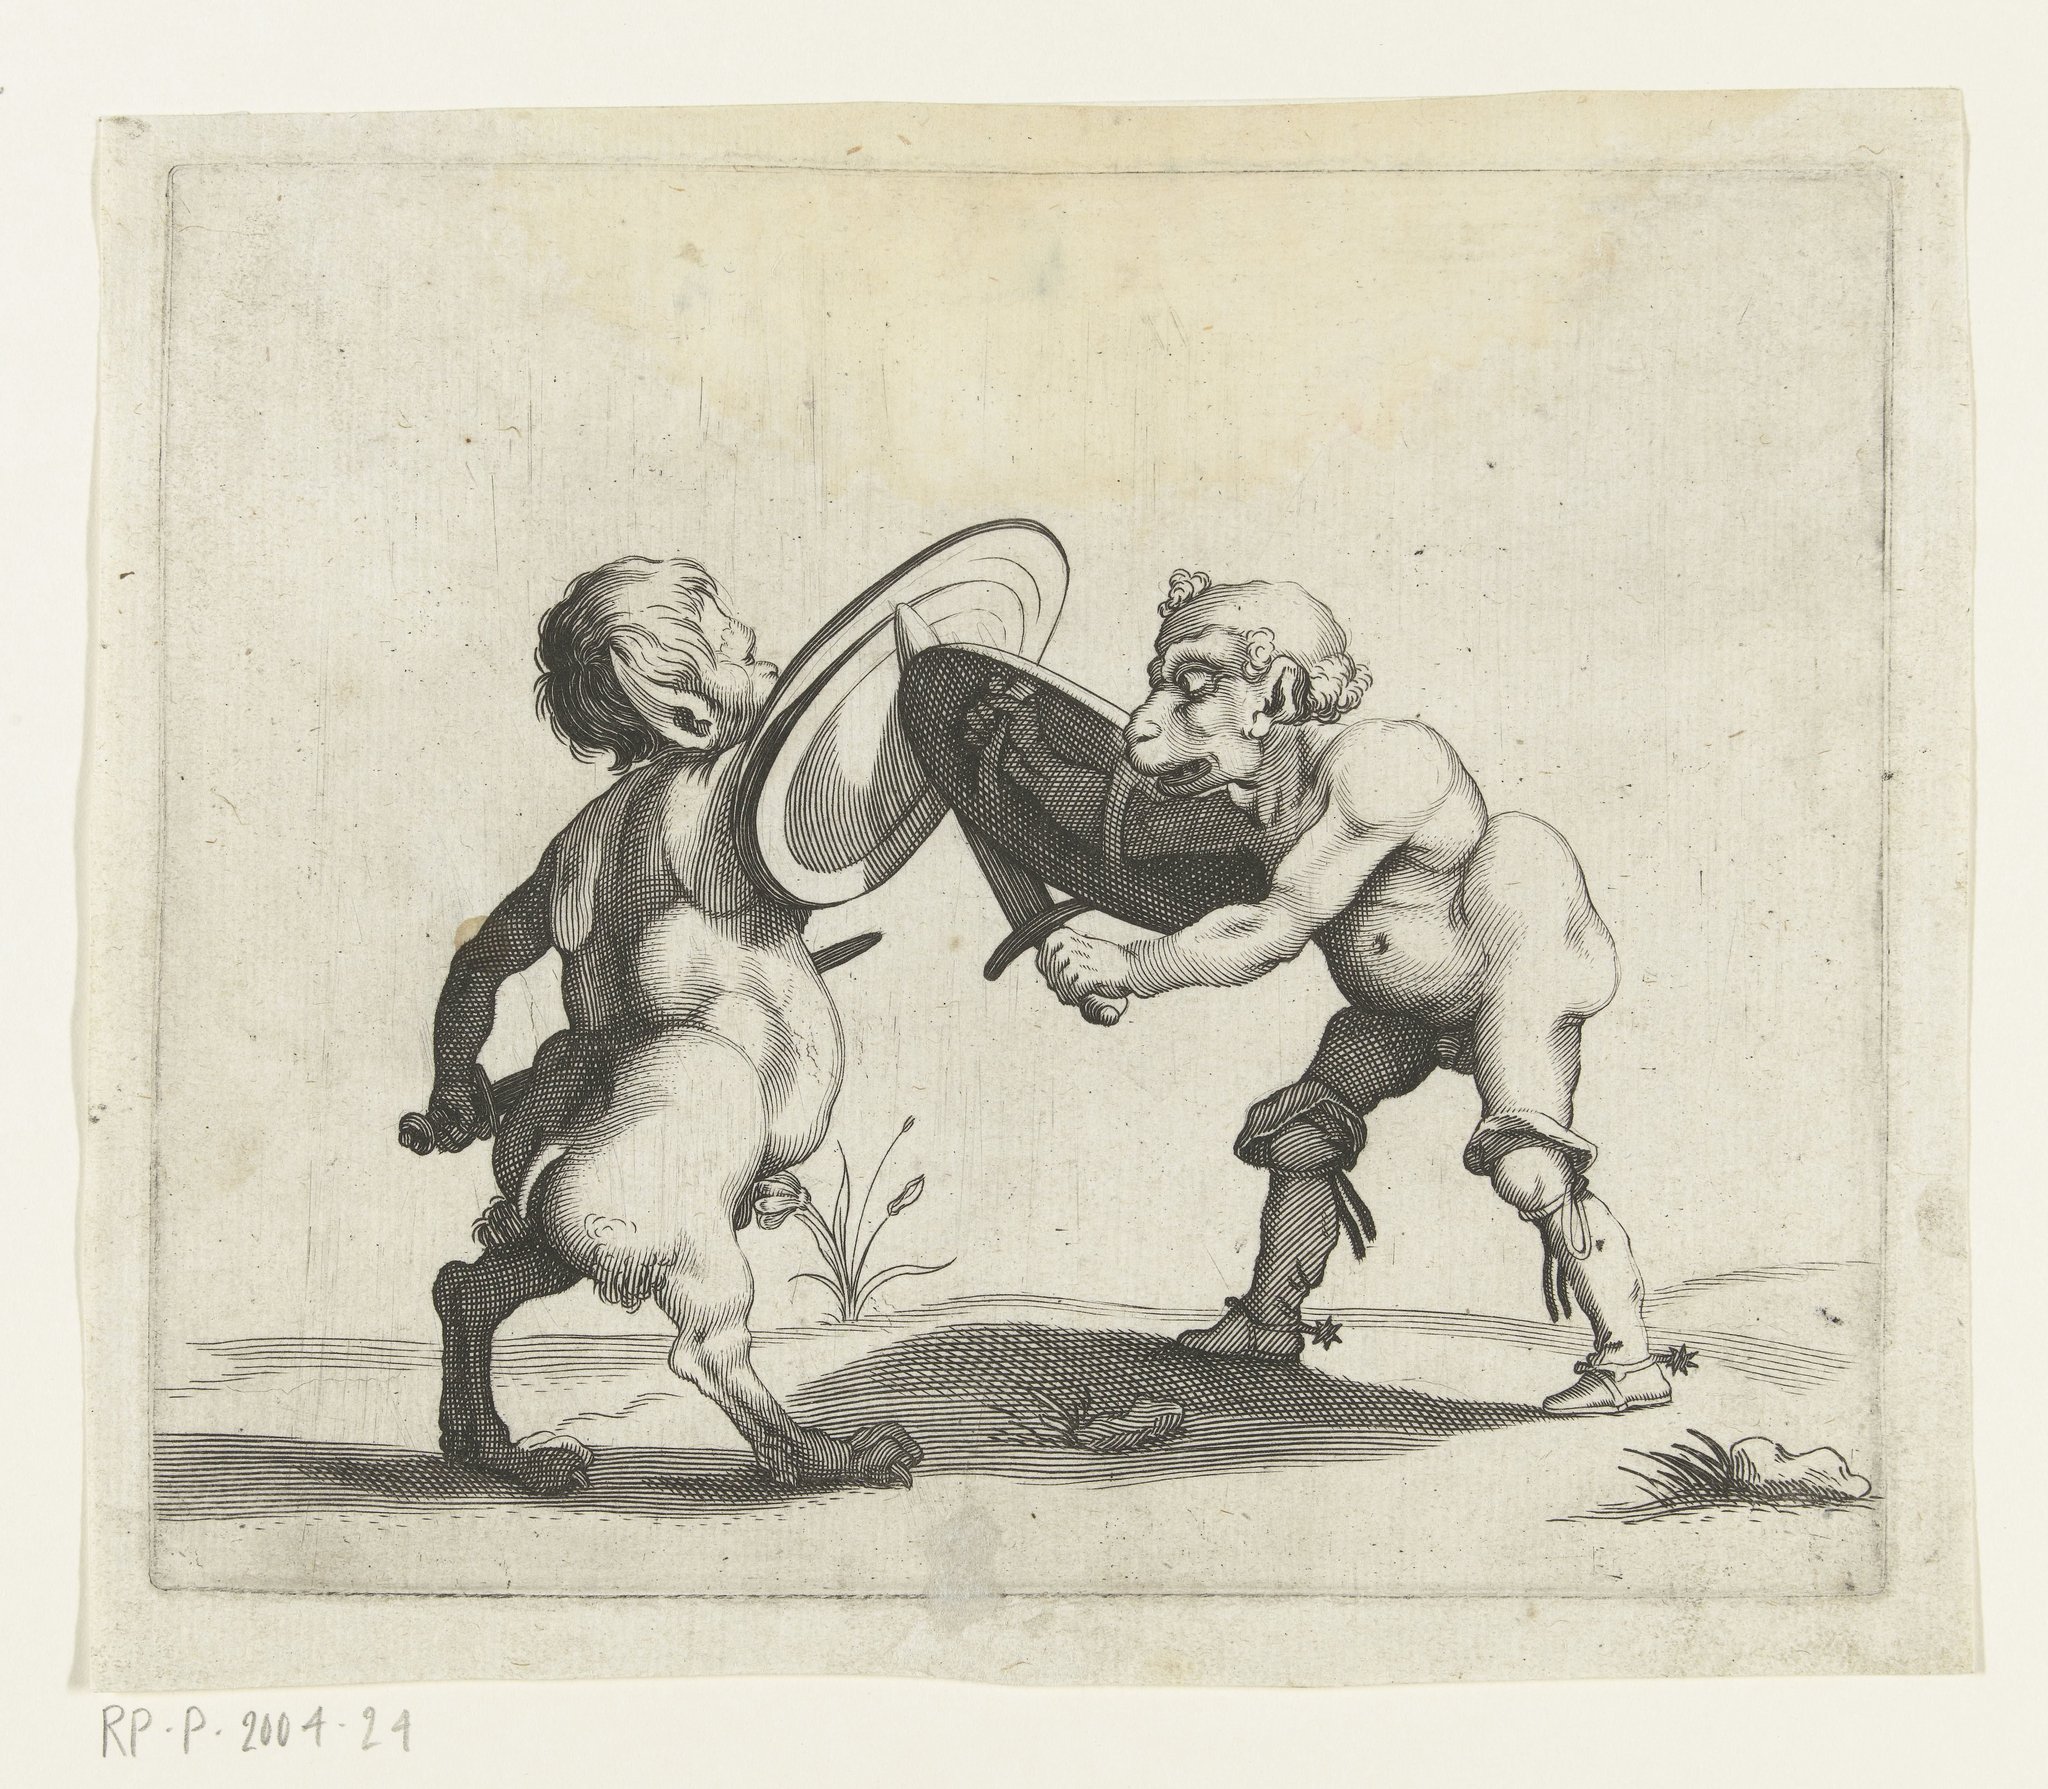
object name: print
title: Twee grotesken met zwaard en schild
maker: Anonymous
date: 1600-1625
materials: paper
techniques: engraving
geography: netherlands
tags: ornament ~ grotesque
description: Twee groteske figuren, half mens, half dier, tegen over elkaar met zward en schild. Uit serie van 12